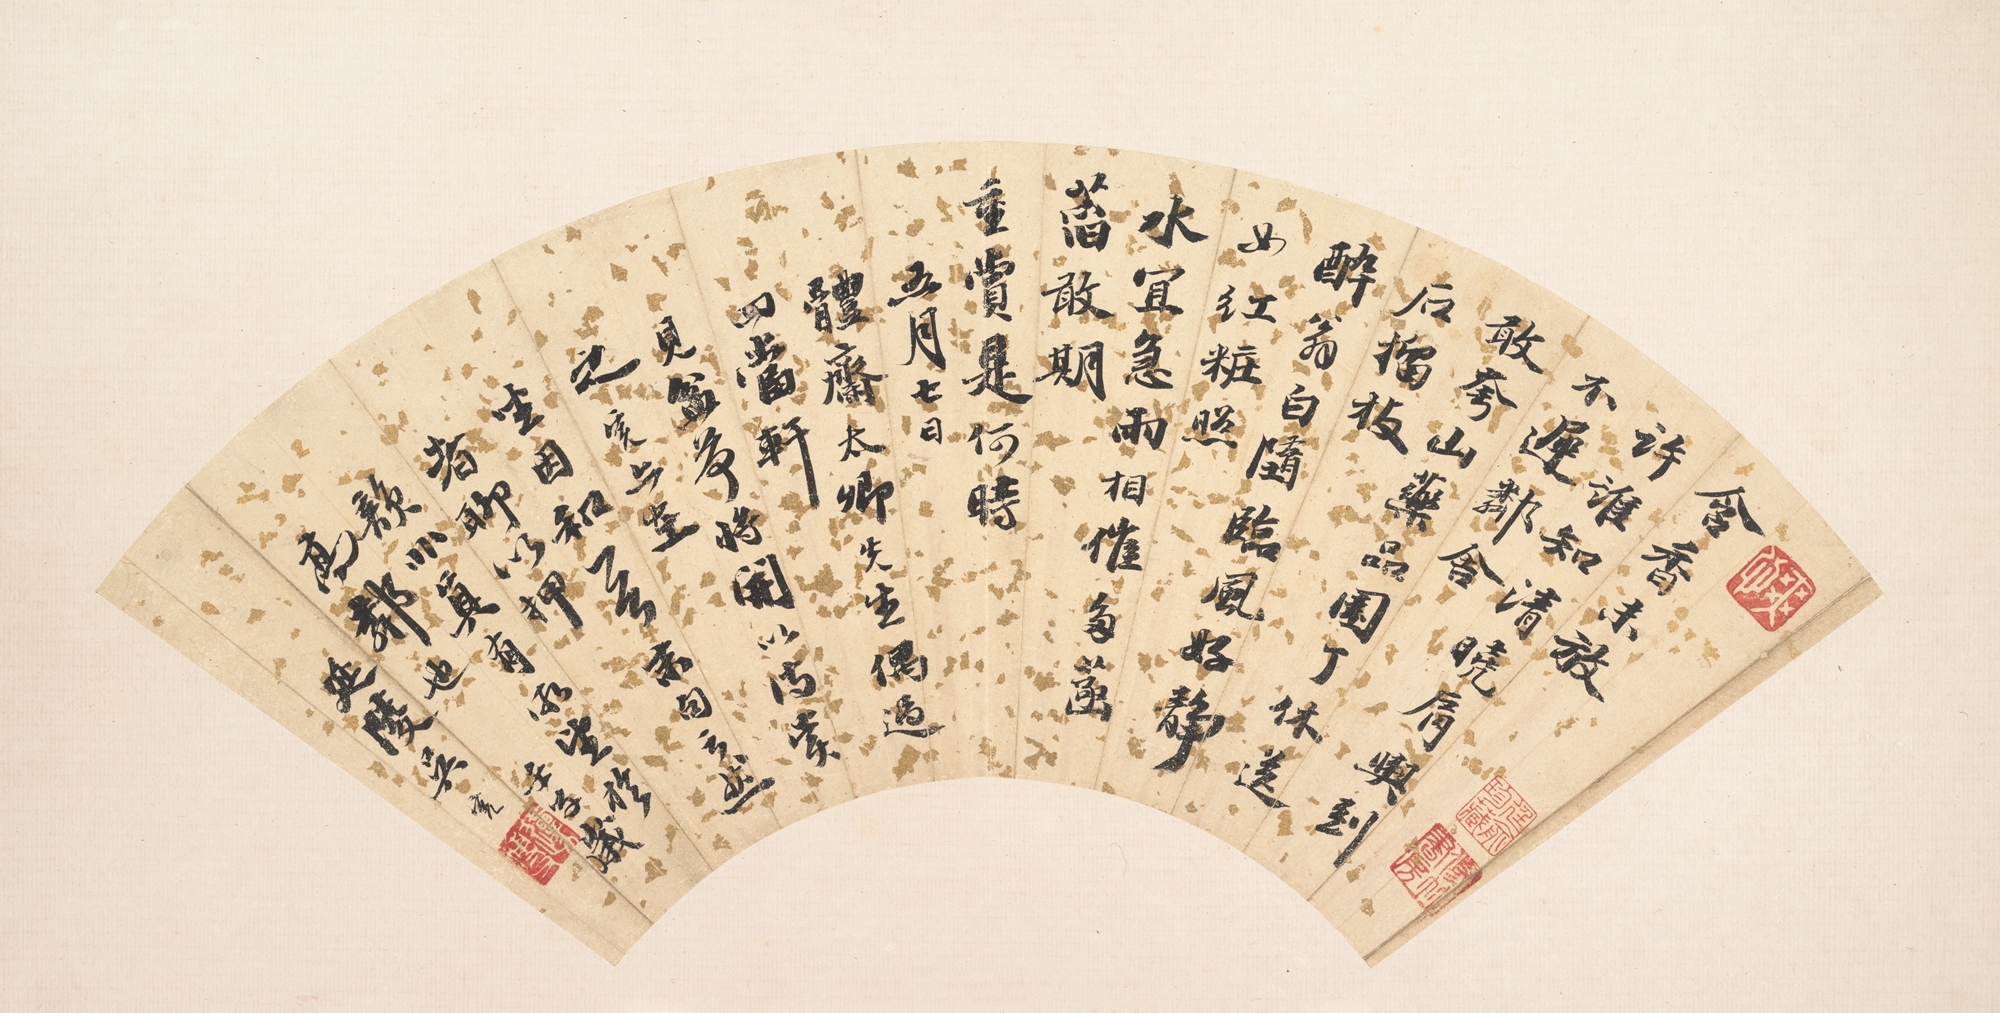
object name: folding fan mounted a an album leaf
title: Calligraphy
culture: chinese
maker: unidentified artist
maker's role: artist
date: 1701-1800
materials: gold, ink, paper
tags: calligraphy